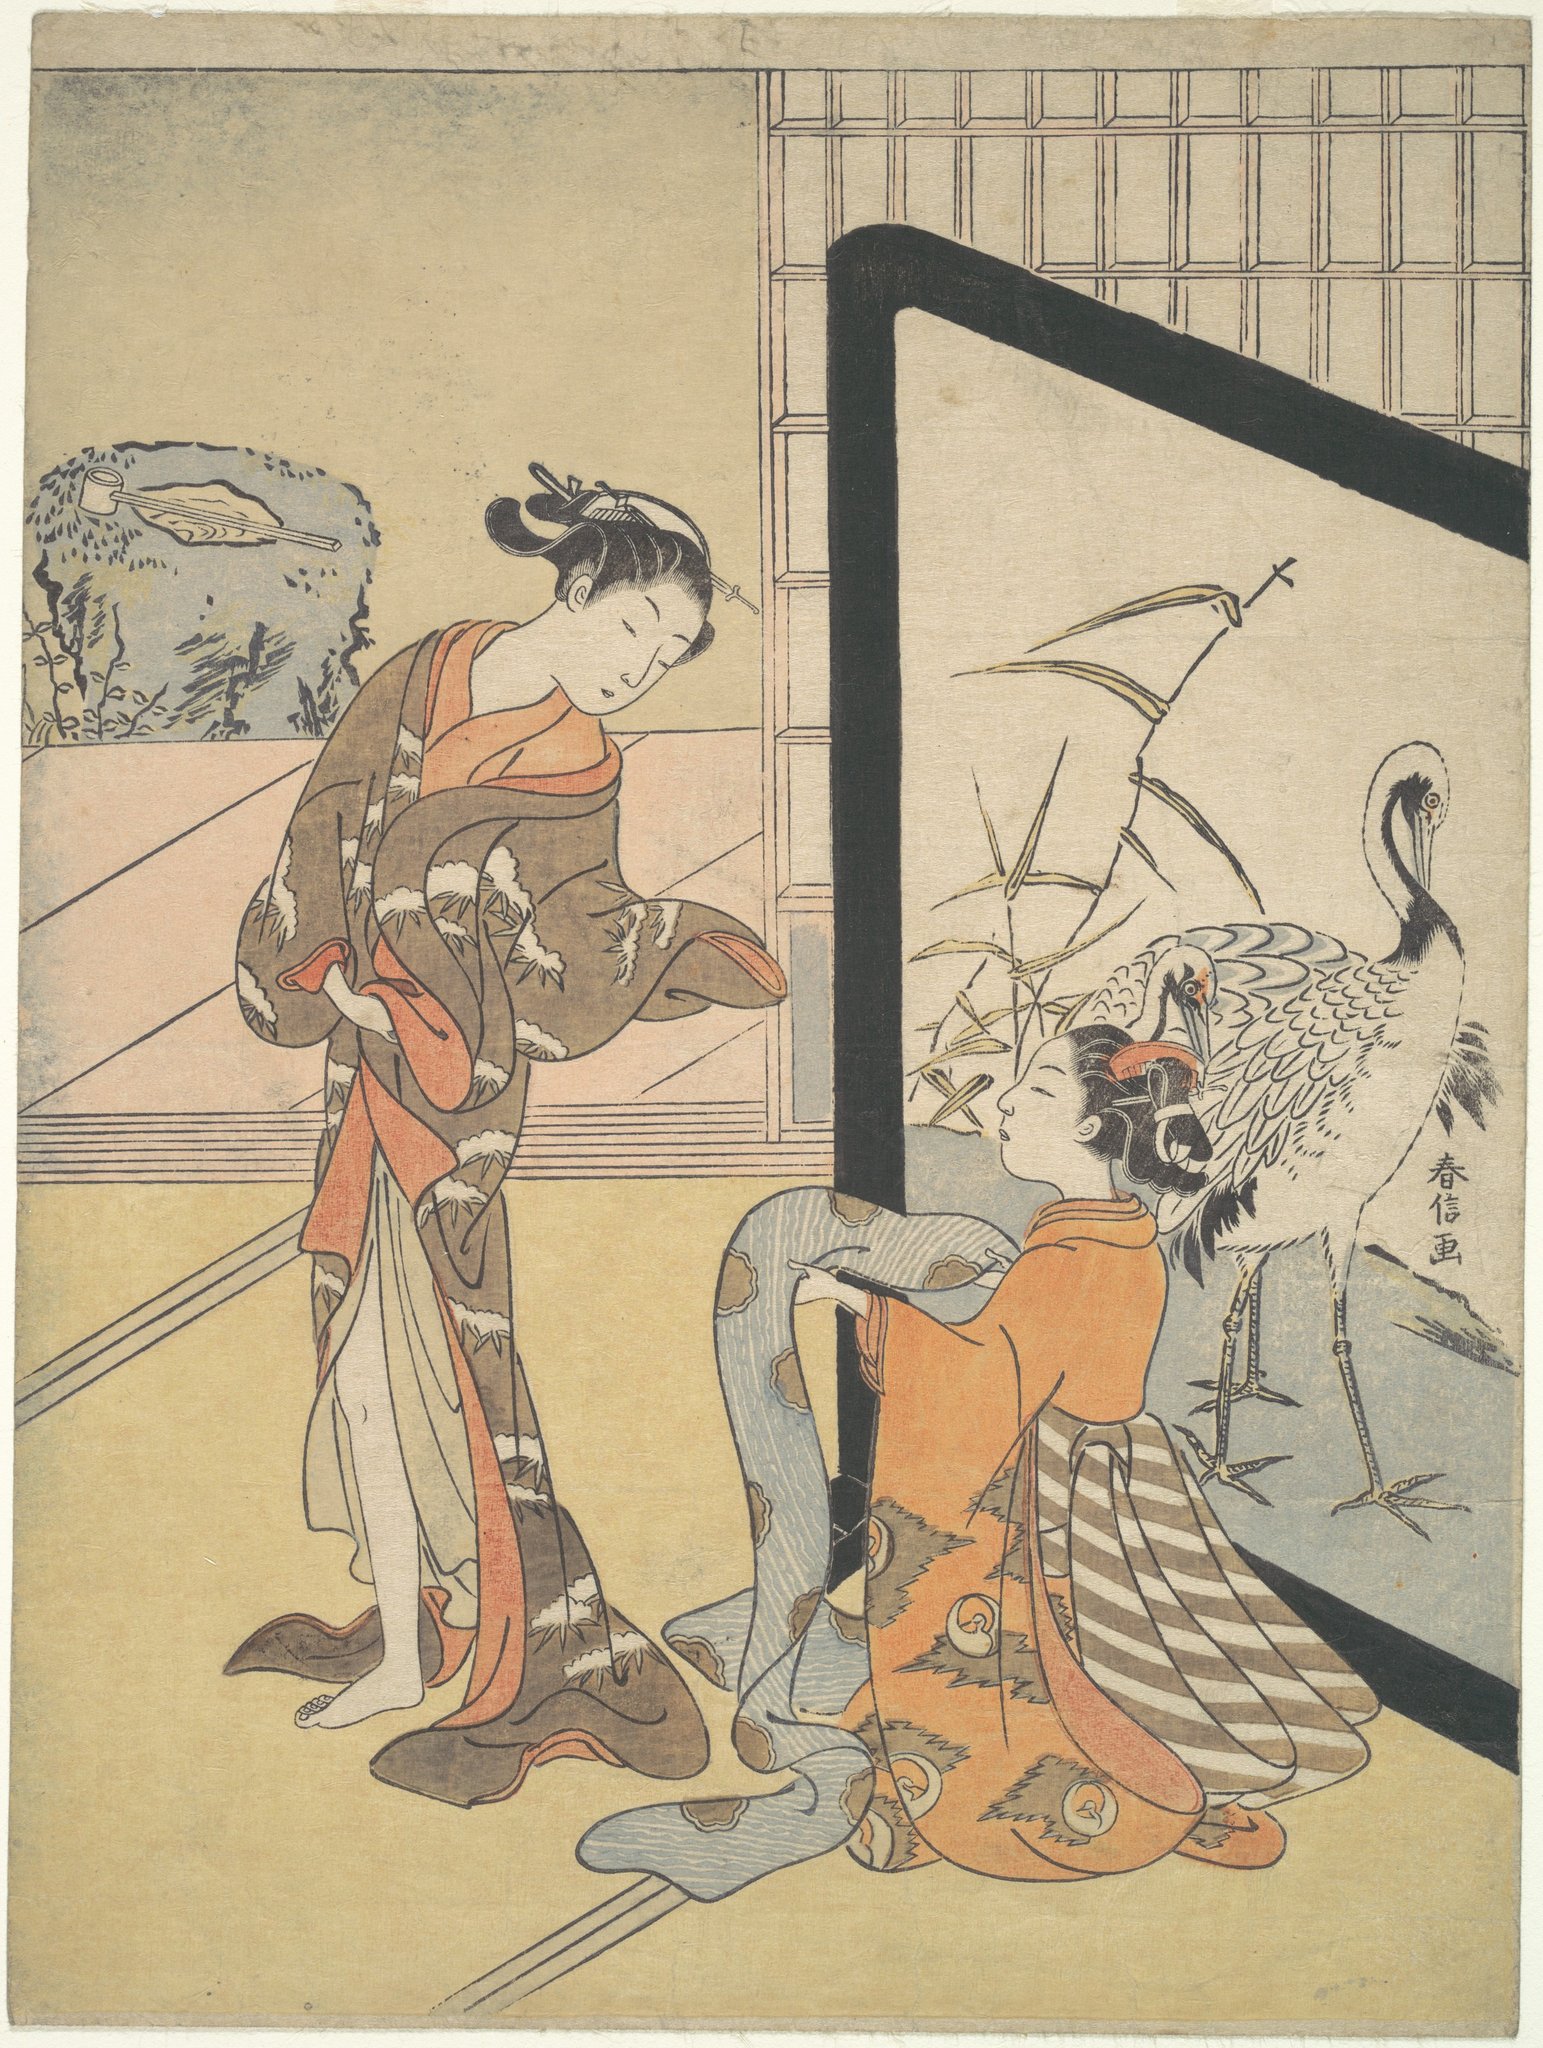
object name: woodblock print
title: Courtesan and Shinzō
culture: japanese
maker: suzuki harunobu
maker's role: artist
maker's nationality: japanese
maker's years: 1725-1770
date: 1725-1770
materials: ink, paper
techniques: woodblock print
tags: cranes,women